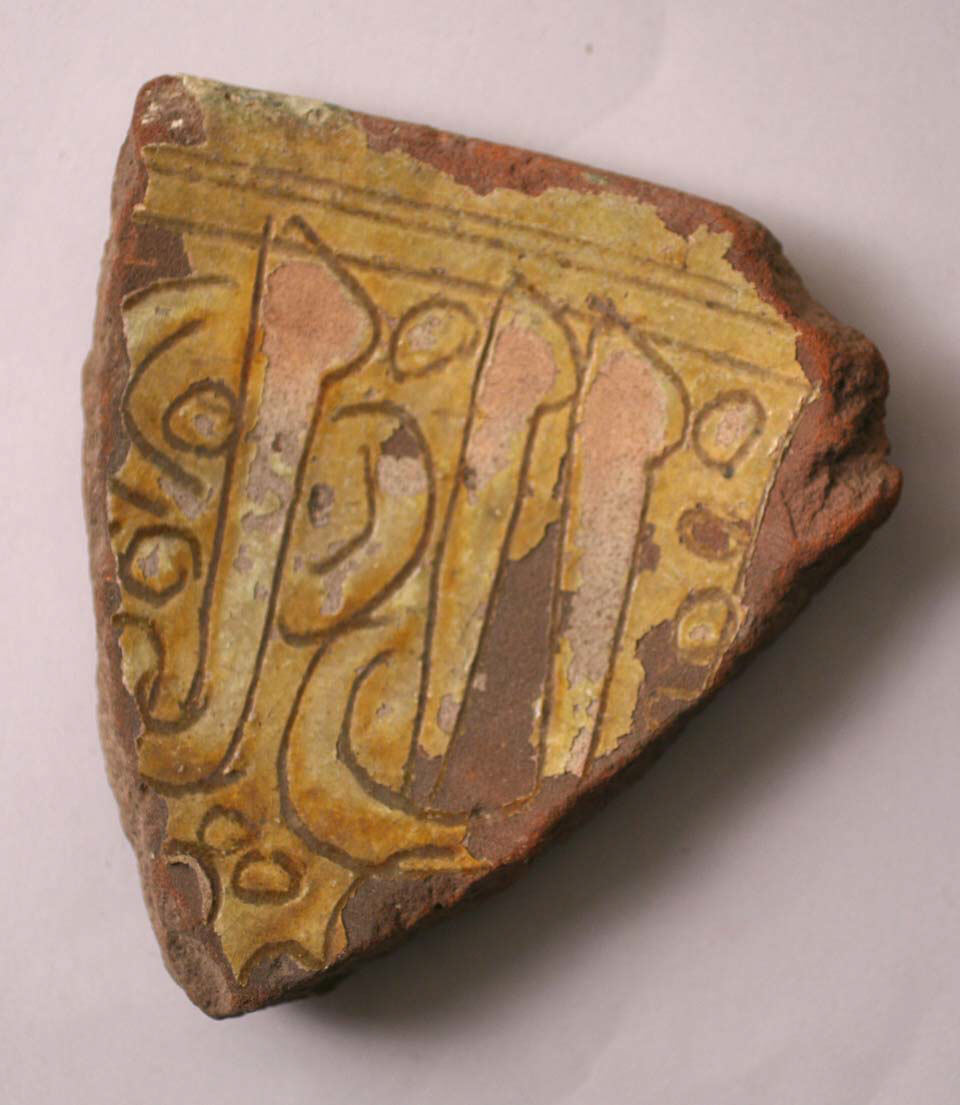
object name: fragment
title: Ceramic Fragment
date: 1301-1500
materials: earthenware, glaze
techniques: coloring, incising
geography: egypt